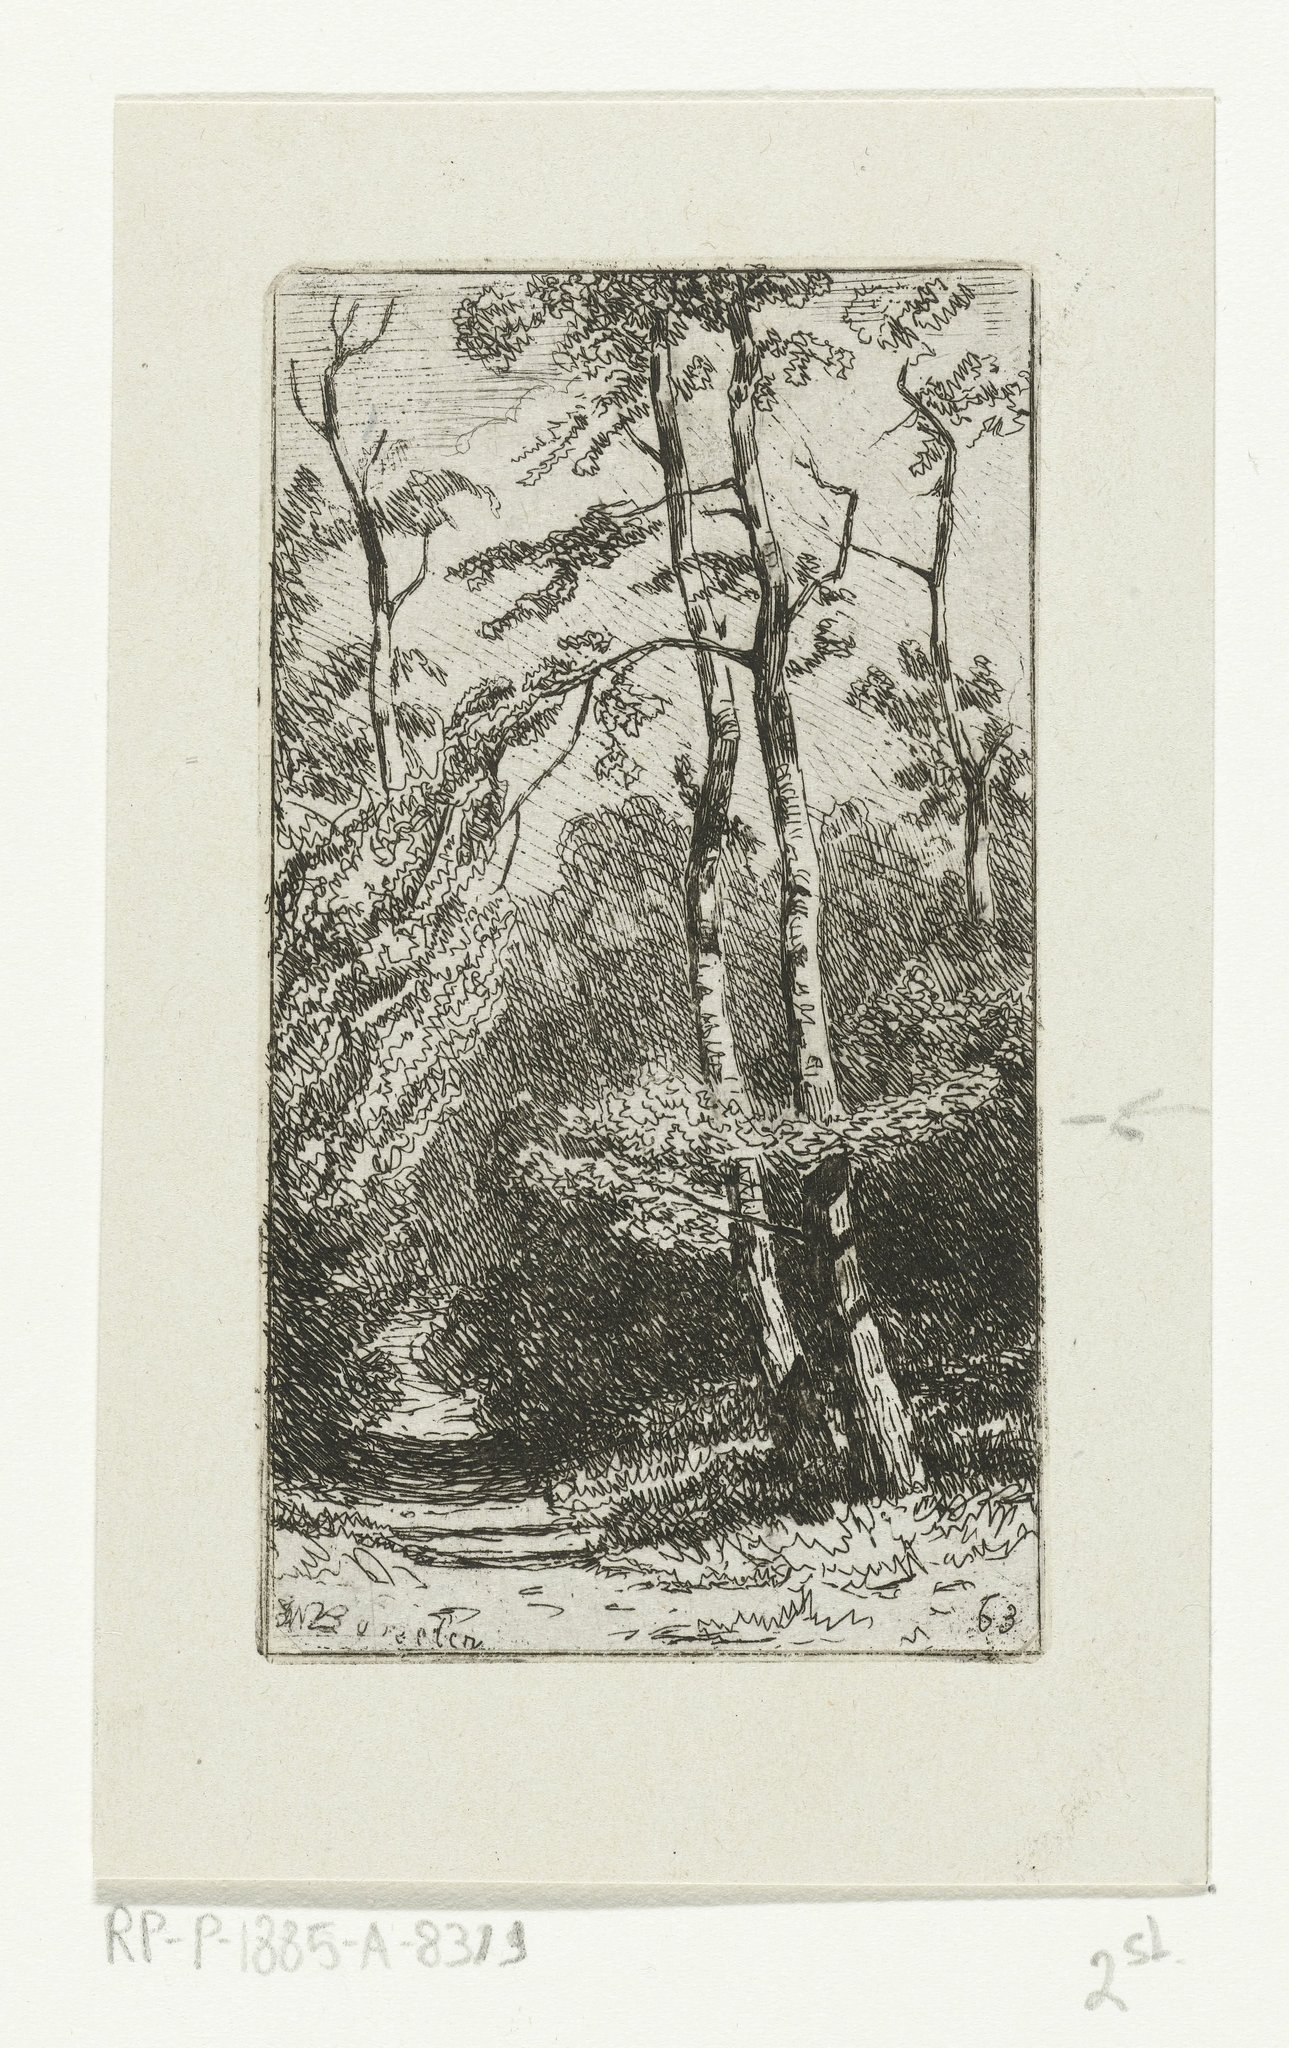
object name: print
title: Landschap met berken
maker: jan willem van borselen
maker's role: draughtsman, print maker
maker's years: 1825-1892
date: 1835-1885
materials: paper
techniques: etching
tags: forest path or lane, trees: birch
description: Landschap met een bosweggetje en enkele berken.